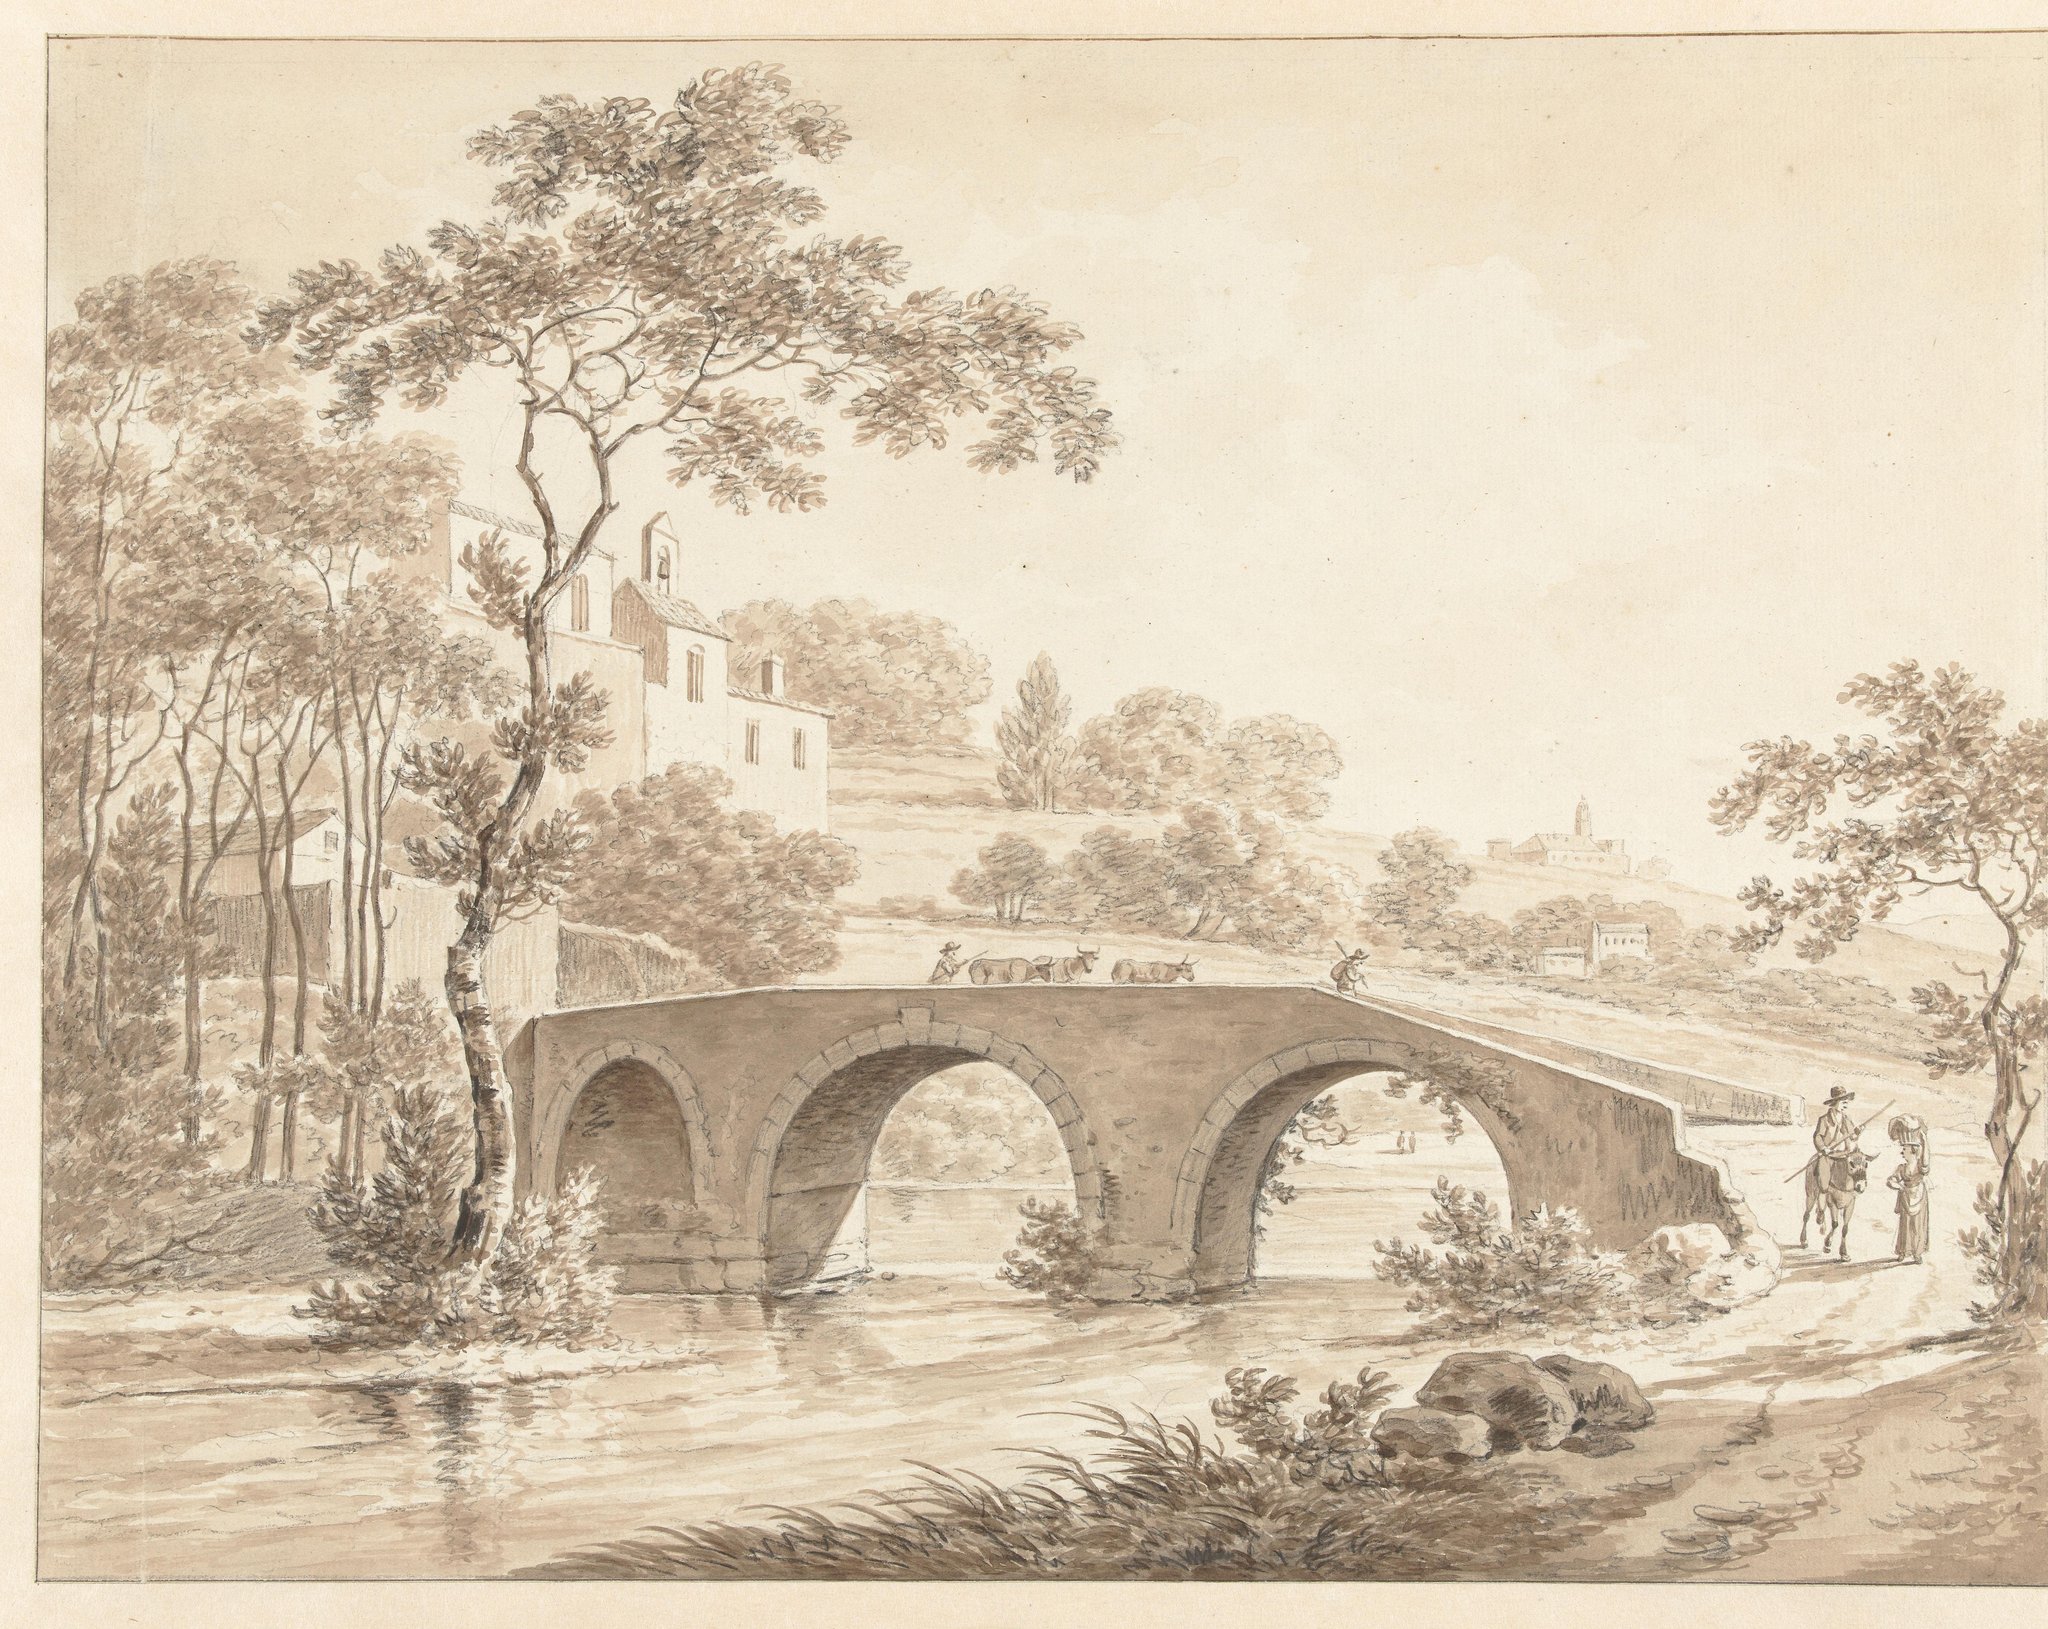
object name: drawing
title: De brug over de Tiber bij Narni in de Romeinse Campagna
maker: daniël dupré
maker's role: draughtsman, print maker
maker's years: 1751-1817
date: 1761-1817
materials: chalk, ink, paper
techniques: brush, pen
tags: landscape with bridge, viaduct or aqueduct, italy